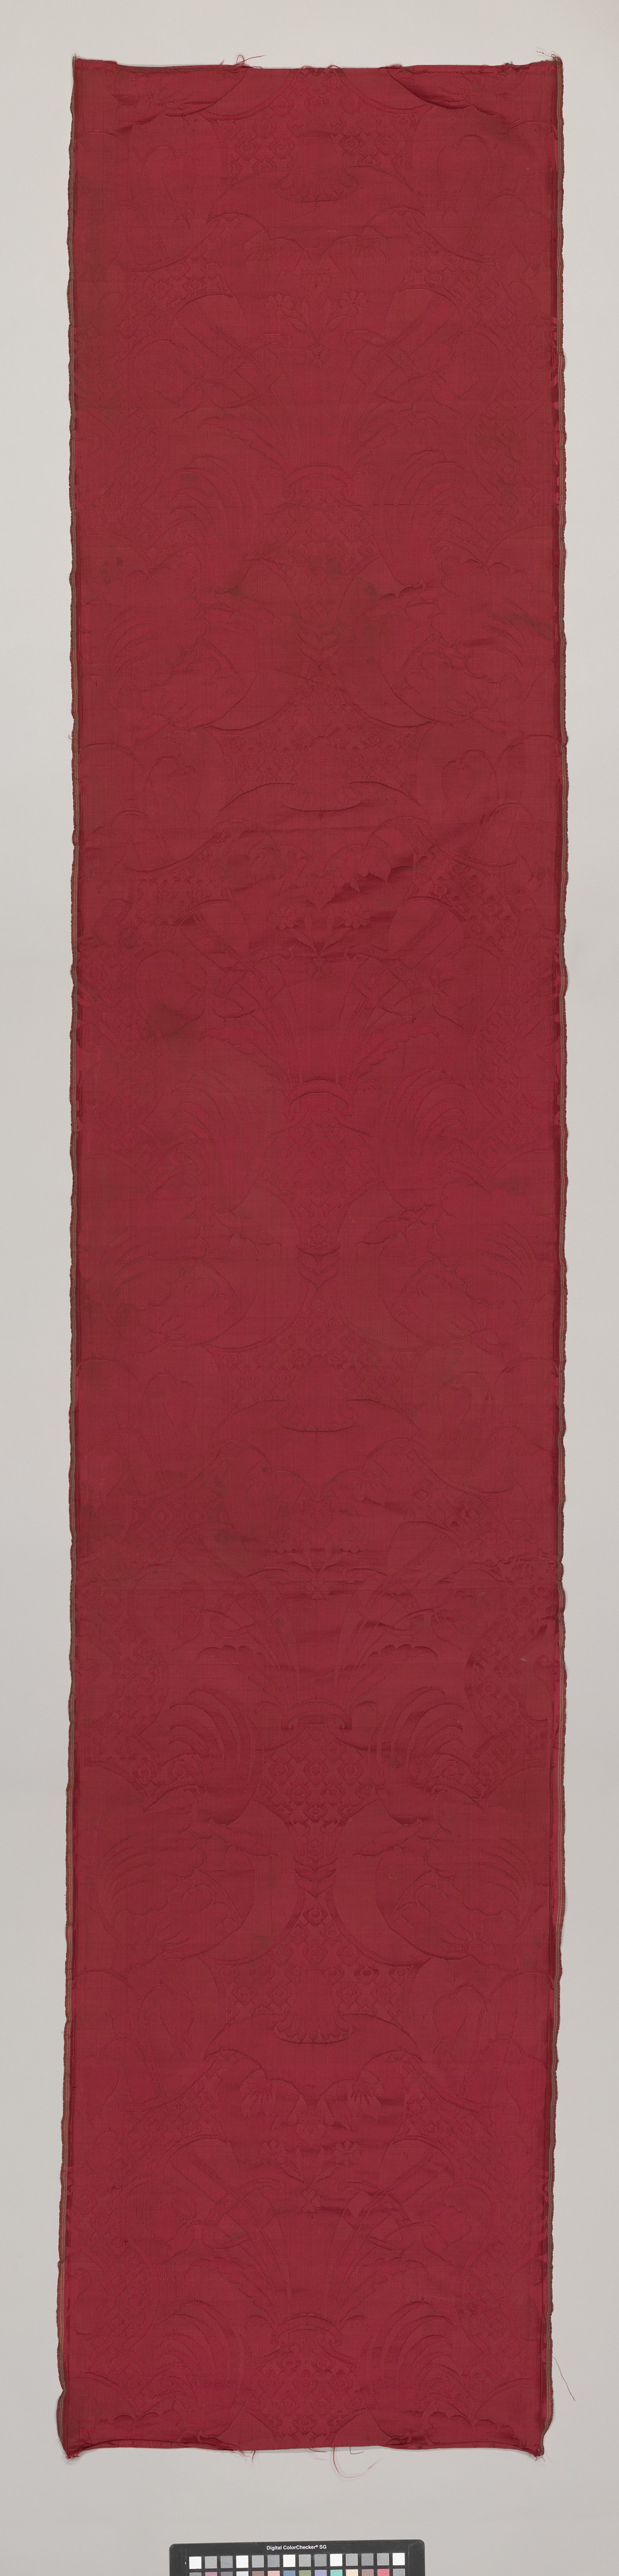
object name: furnishing textile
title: Furnishing damask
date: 1700-1725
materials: silk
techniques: damask